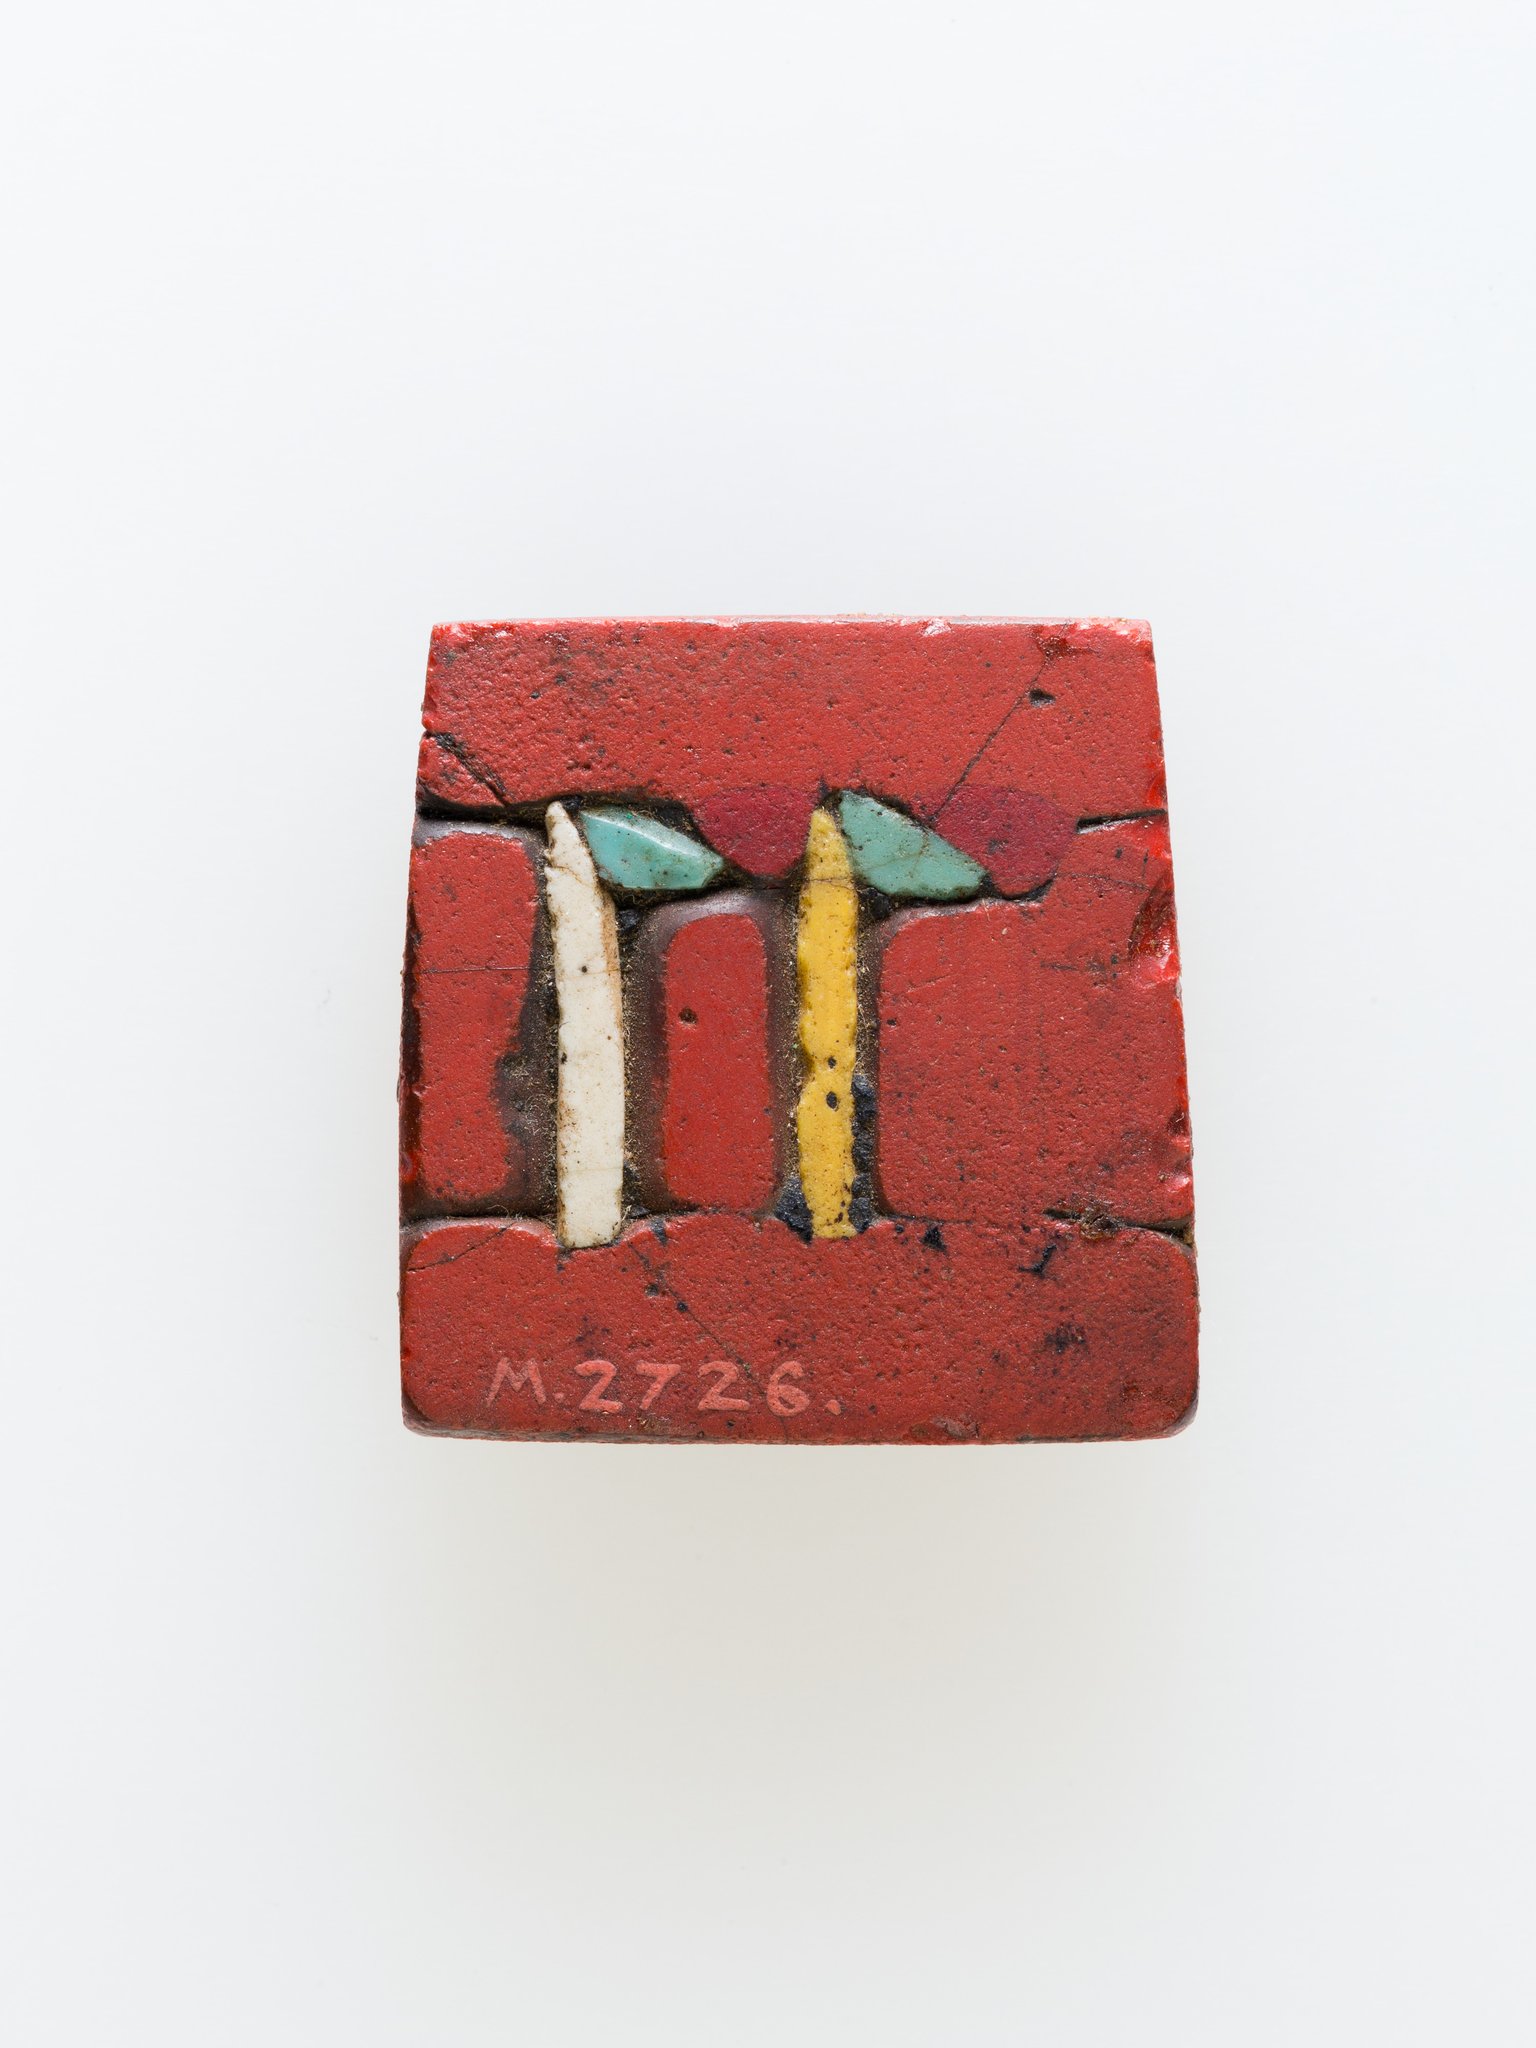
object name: inlay, hieroglyph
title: Inlay square, 2 hieroglyphs for god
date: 200 BCE-100 CE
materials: glass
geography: egypt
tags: hieroglyphs